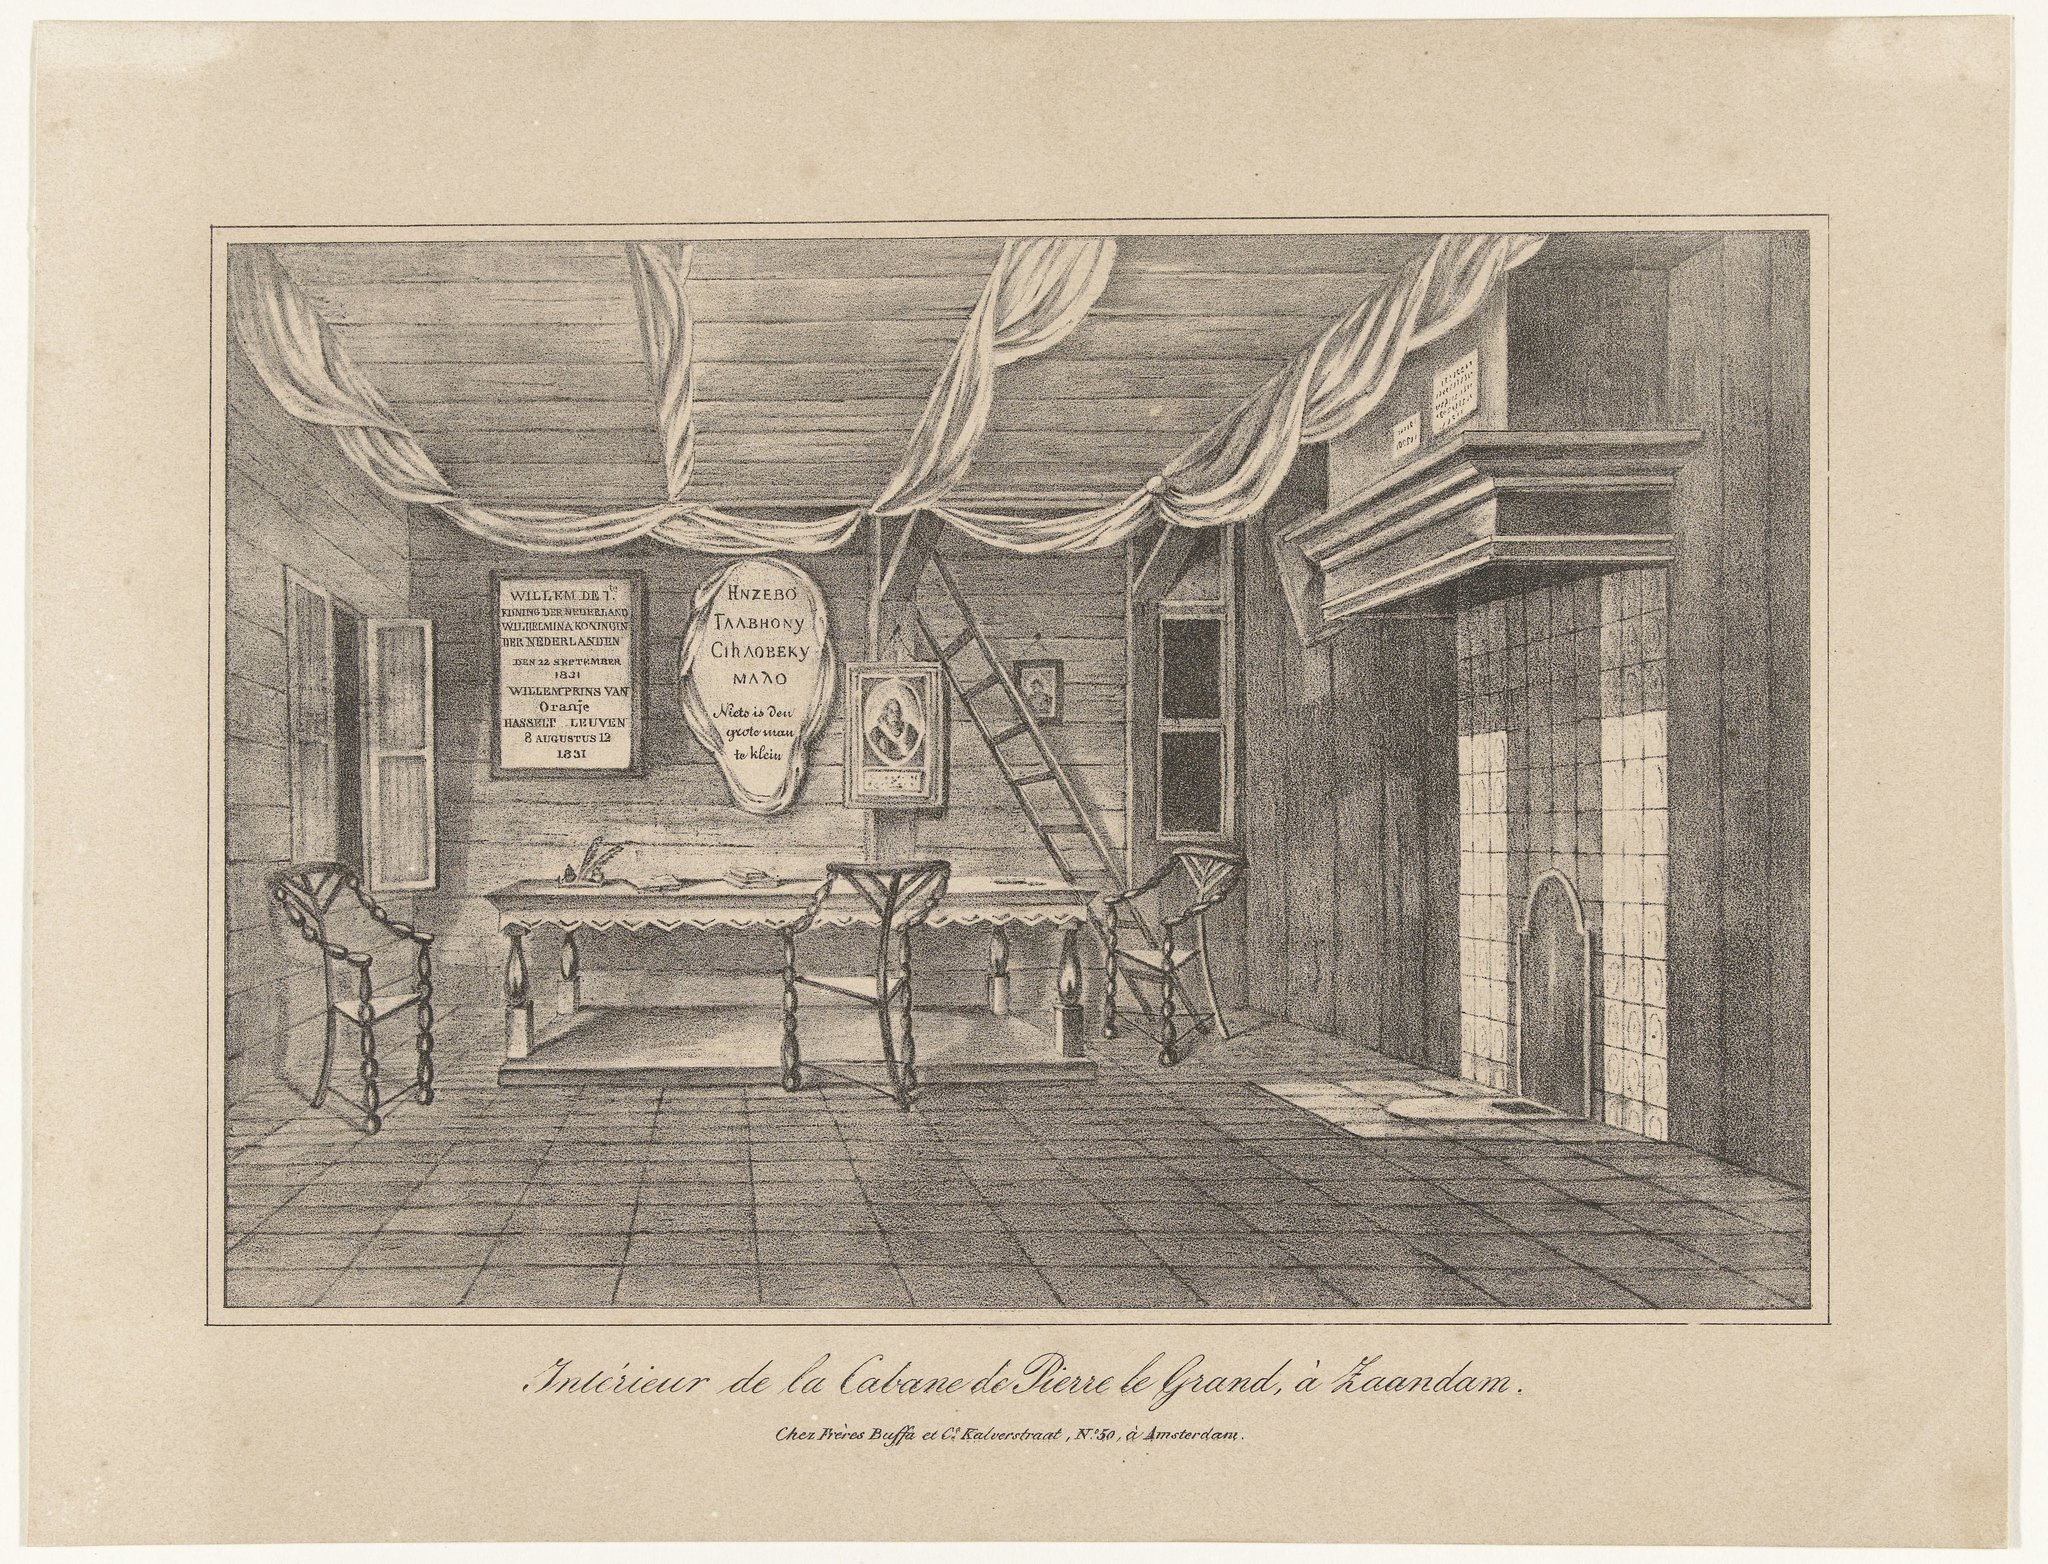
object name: print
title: Interieur van het Tsaar Peterhuisje te Zaandam, 1697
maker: Anonymous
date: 1831-1899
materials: paper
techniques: lithograph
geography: netherlands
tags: peter i de grote (tsaar van rusland)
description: Interieur van het Tsaar Peterhuisje te Zaandam, waar tsaar Peter de Grote verbleef in augustus 1697. Aan de wand een bord geschonken bij het koninklijk bezoek in 1831.